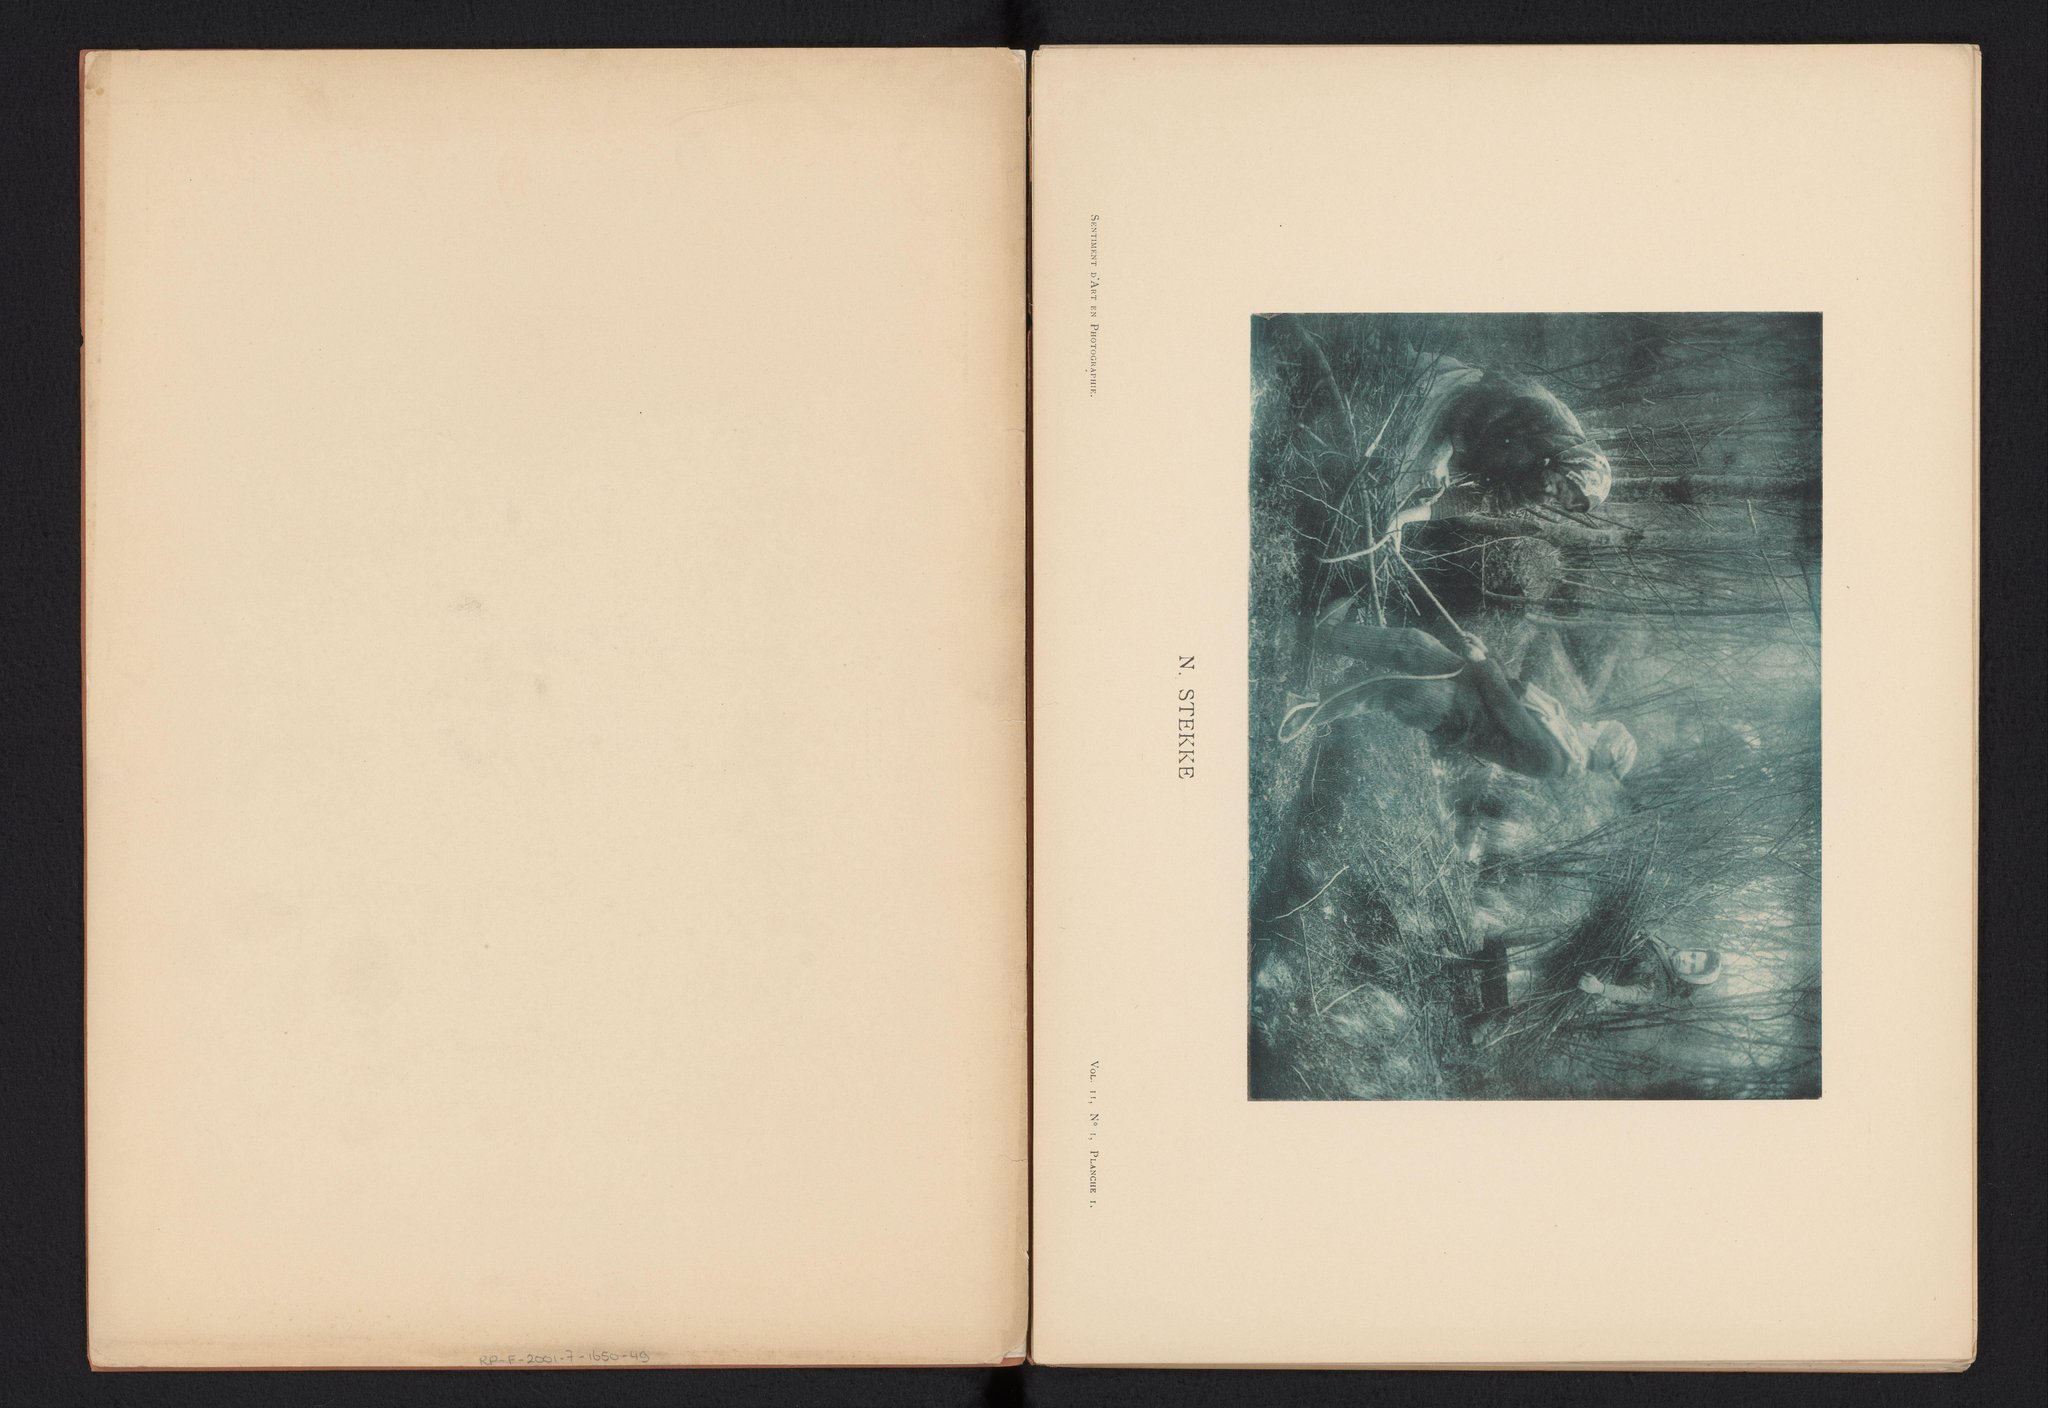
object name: photomechanical print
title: Vrouw, een jongen en een meisje maken bossen van takken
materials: paper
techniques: photograph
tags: forest, wood, mother and child(ren), woman and child(ren) (family group)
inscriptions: number: ‘Vol. II, No 1, Planche 1.’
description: Deze prent maakt deel uit van 8 omslagen met 22 tekstbladen en 89 prenten op losse bladen in en tussen de omslagen.